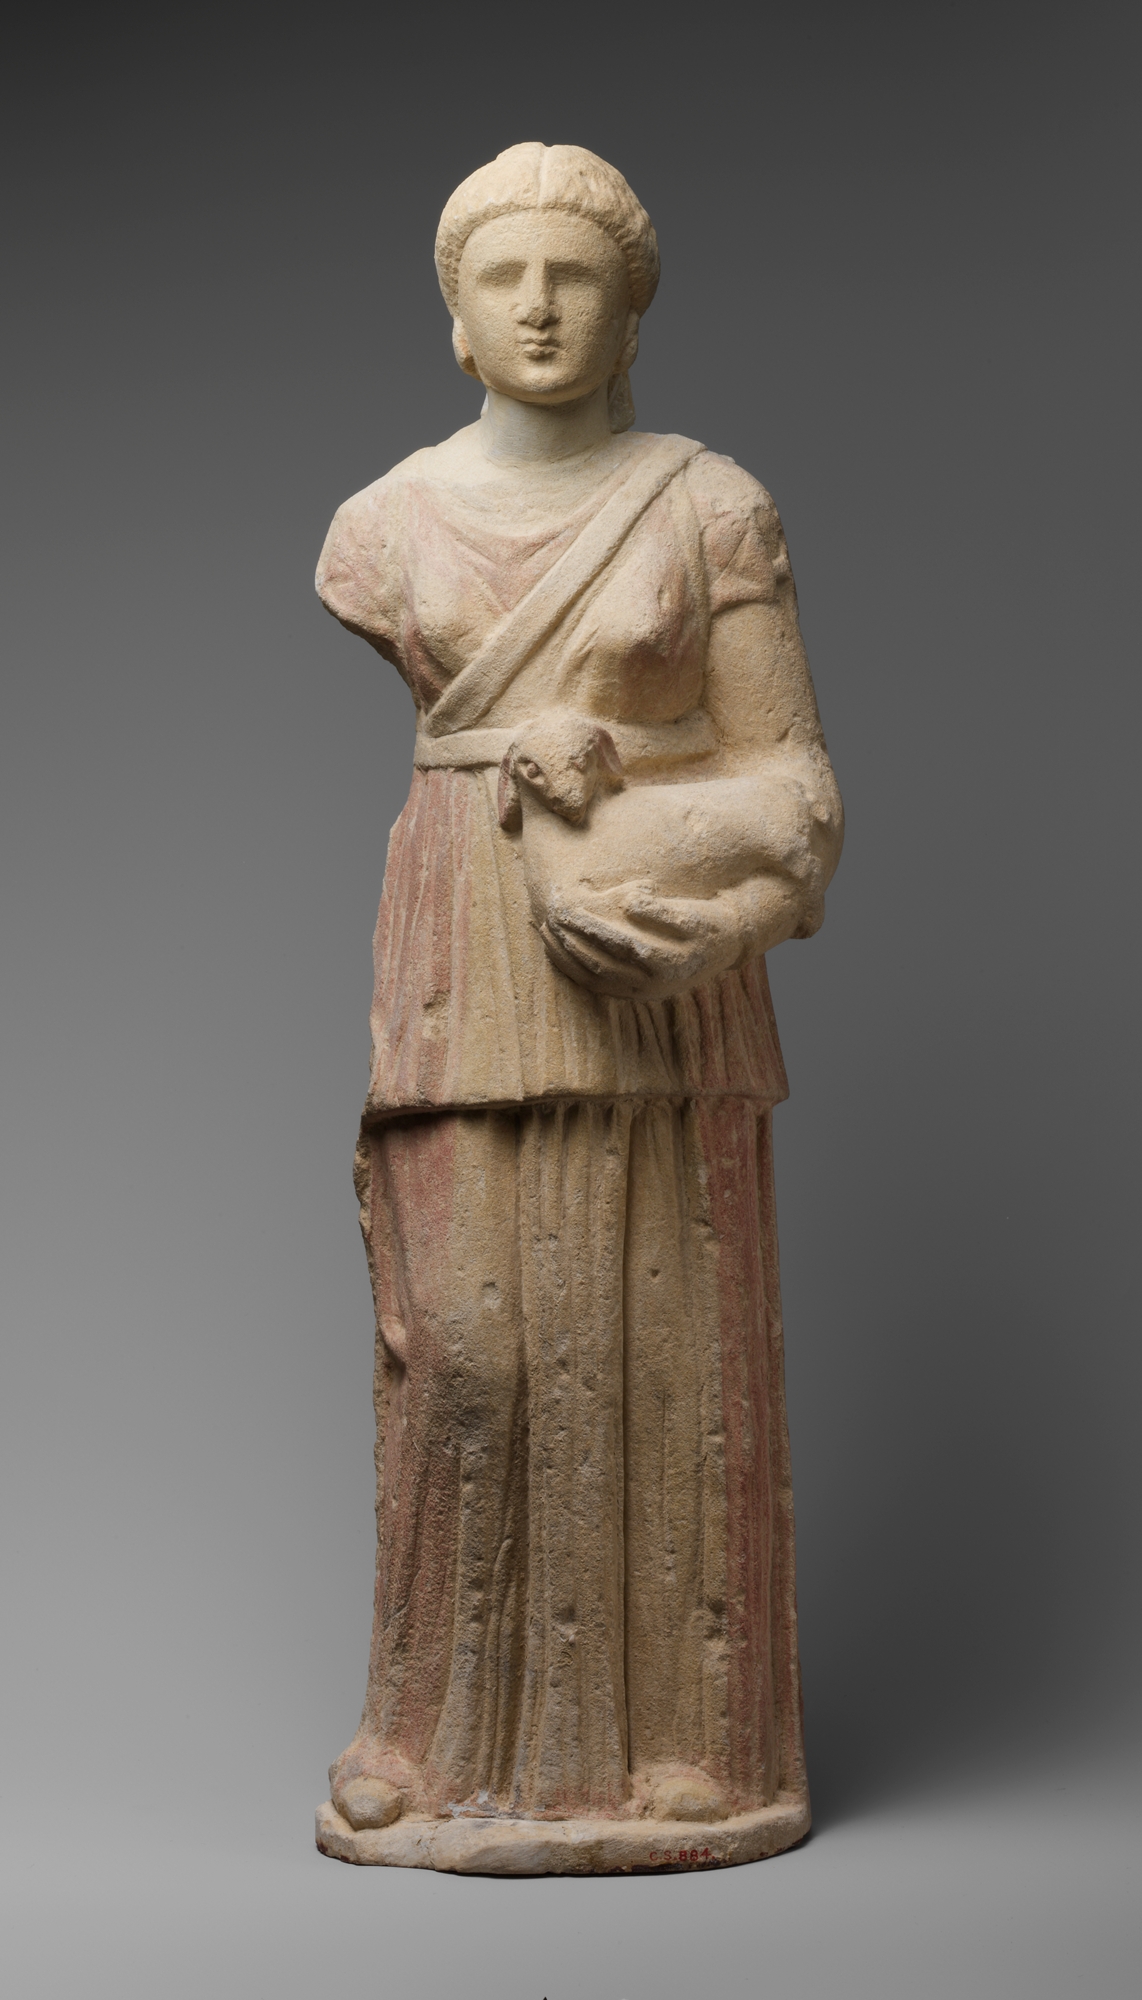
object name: statue of artemis with quiver and fawn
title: Limestone statue of Artemis with quiver and fawn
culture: cypriot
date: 300-1 BCE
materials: limestone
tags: artemis,lambs